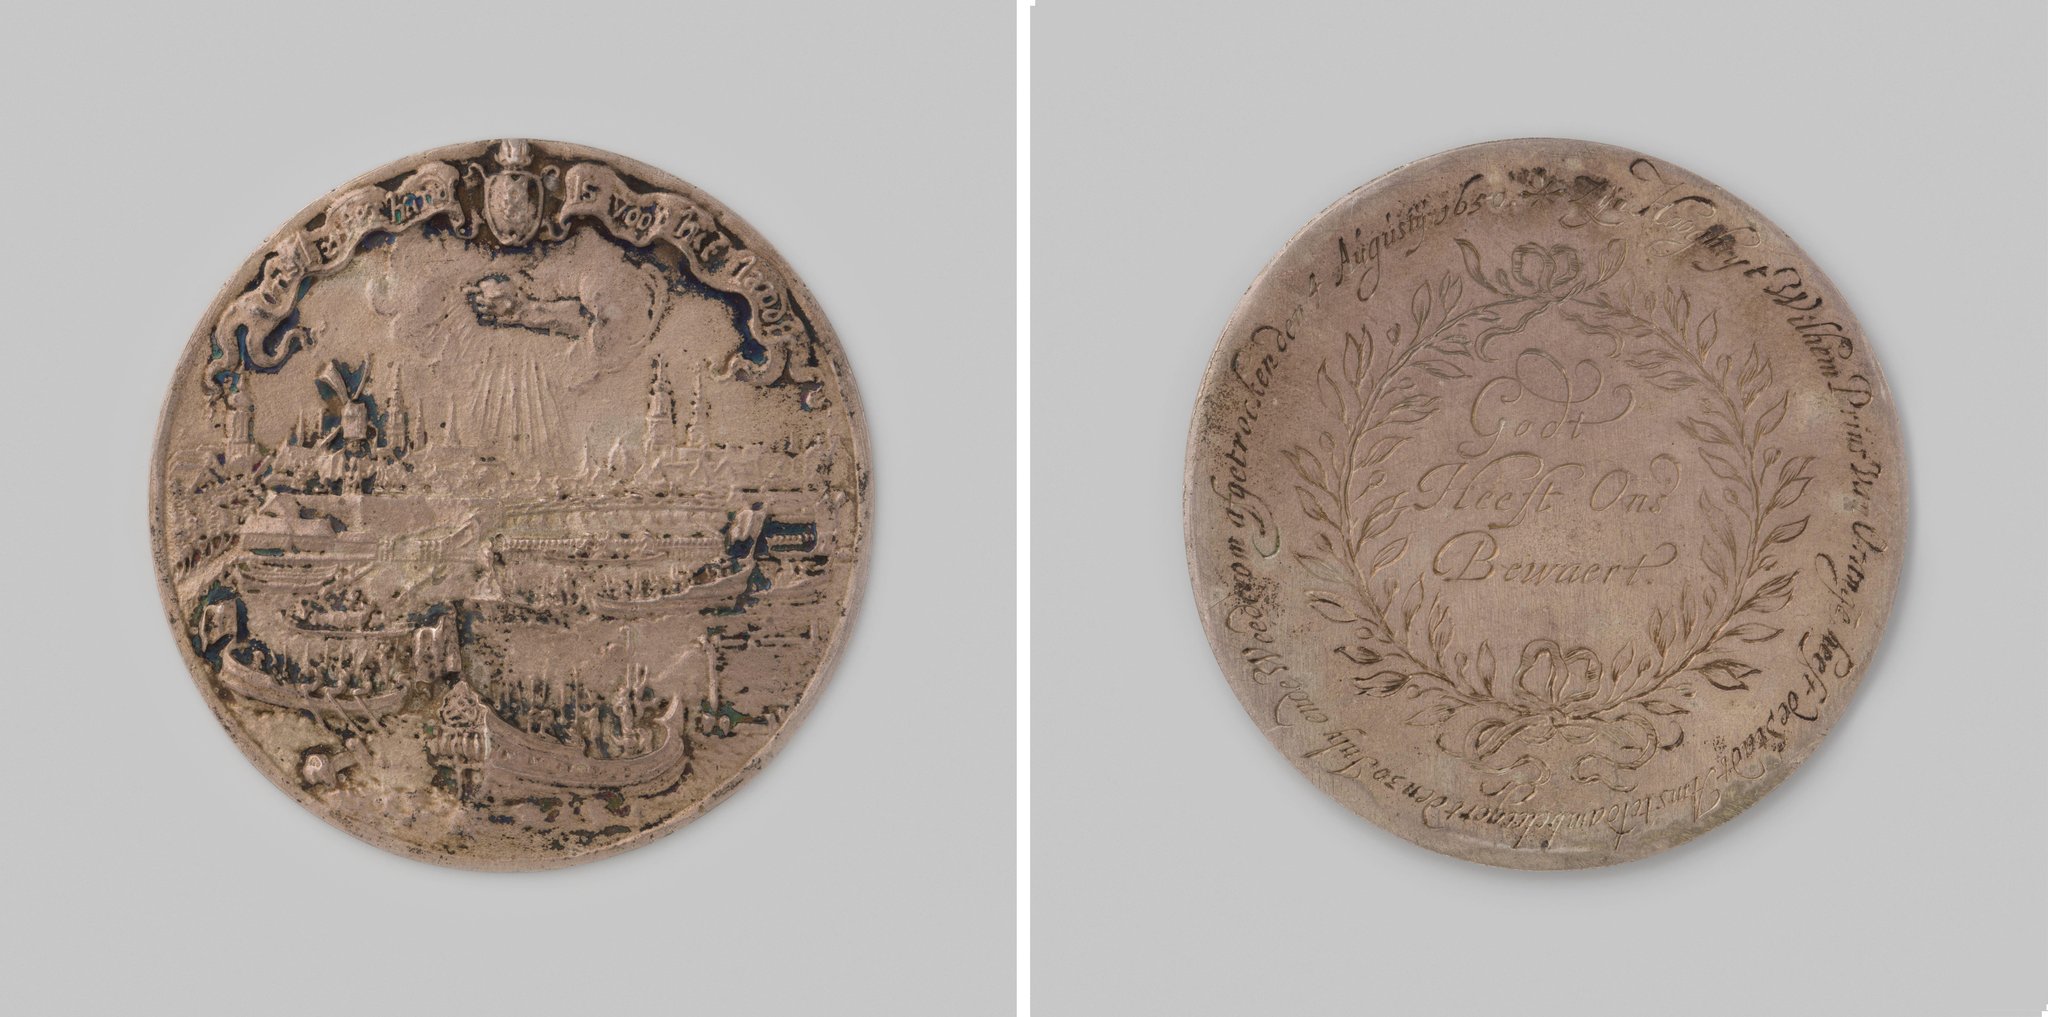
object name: history medal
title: Amsterdam belegerd door Willem II 1650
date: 1650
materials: silver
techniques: casting, engraving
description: Gegoten zilveren penning, op de voorzijde het aanzicht van Amsterdam met schepen vol krijgsvolk en uit de wolken een hand met een hart, bovenaan een lint met tekst en een Amsterdams wapenschild, de keerzijde gegraveerd Godt / Heeft Ons / Bewaert. tussen samengestrikte takken en een omschrift.